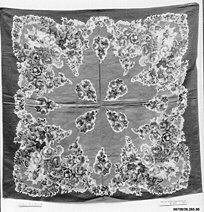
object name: handkerchief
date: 1801-1900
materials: silk